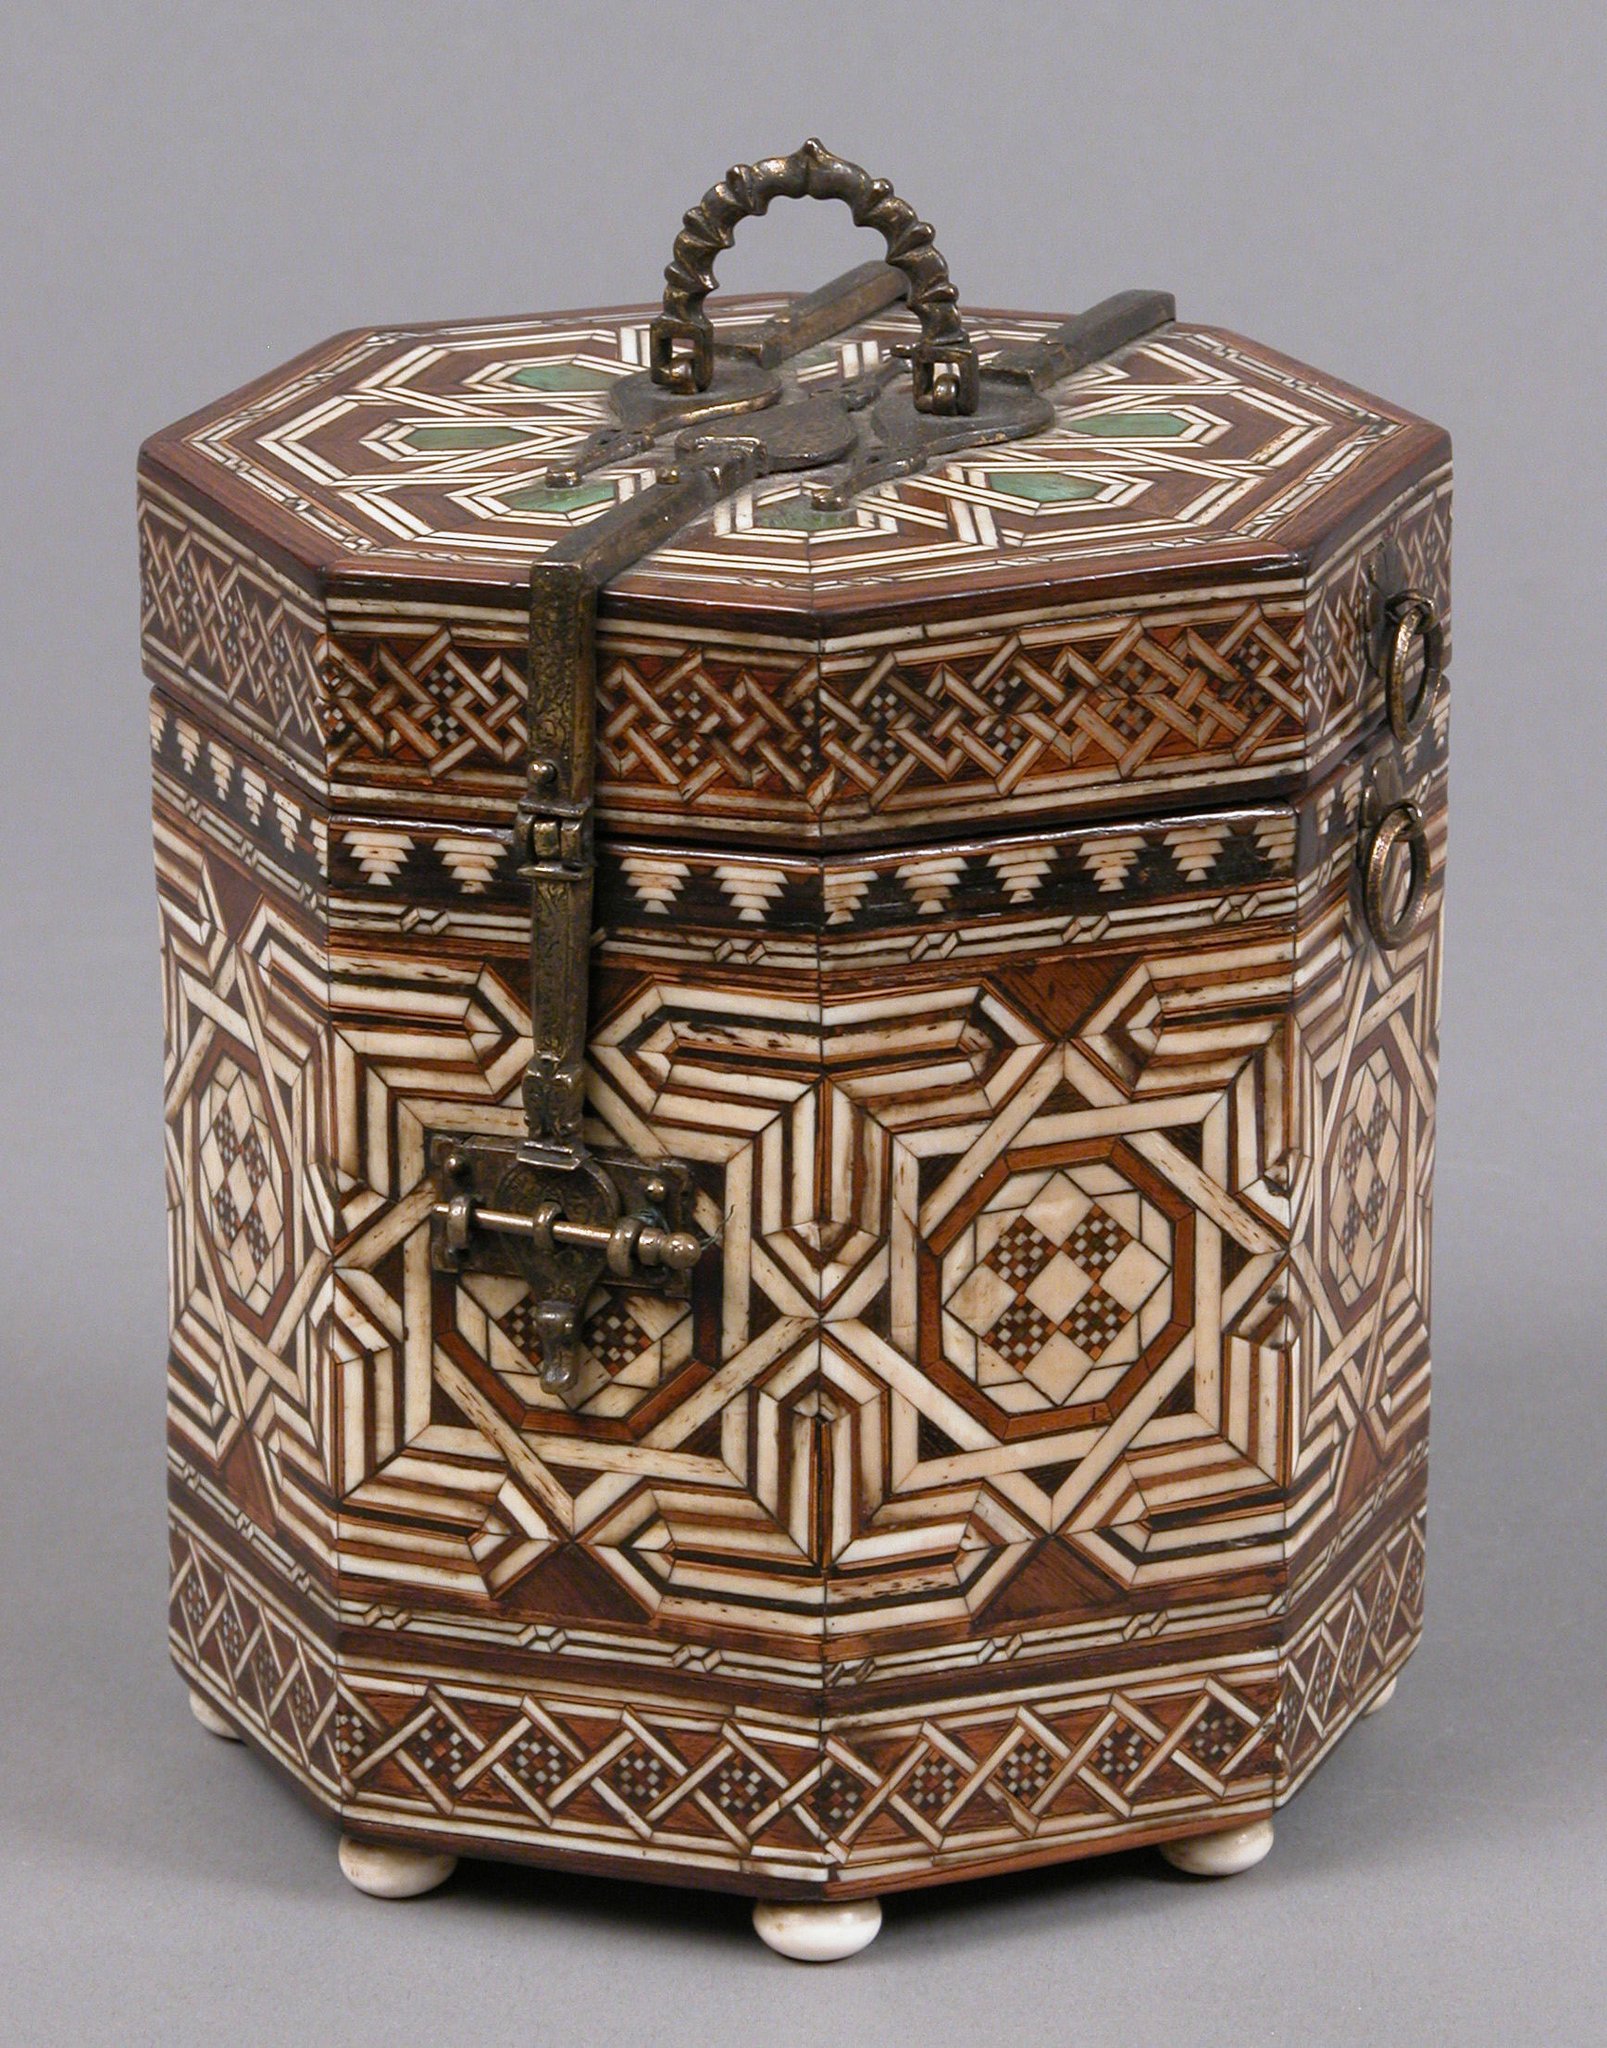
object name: box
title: Octagonal Box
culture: spanish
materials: bone, copper alloy, gilt, ivory, wood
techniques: polychromy